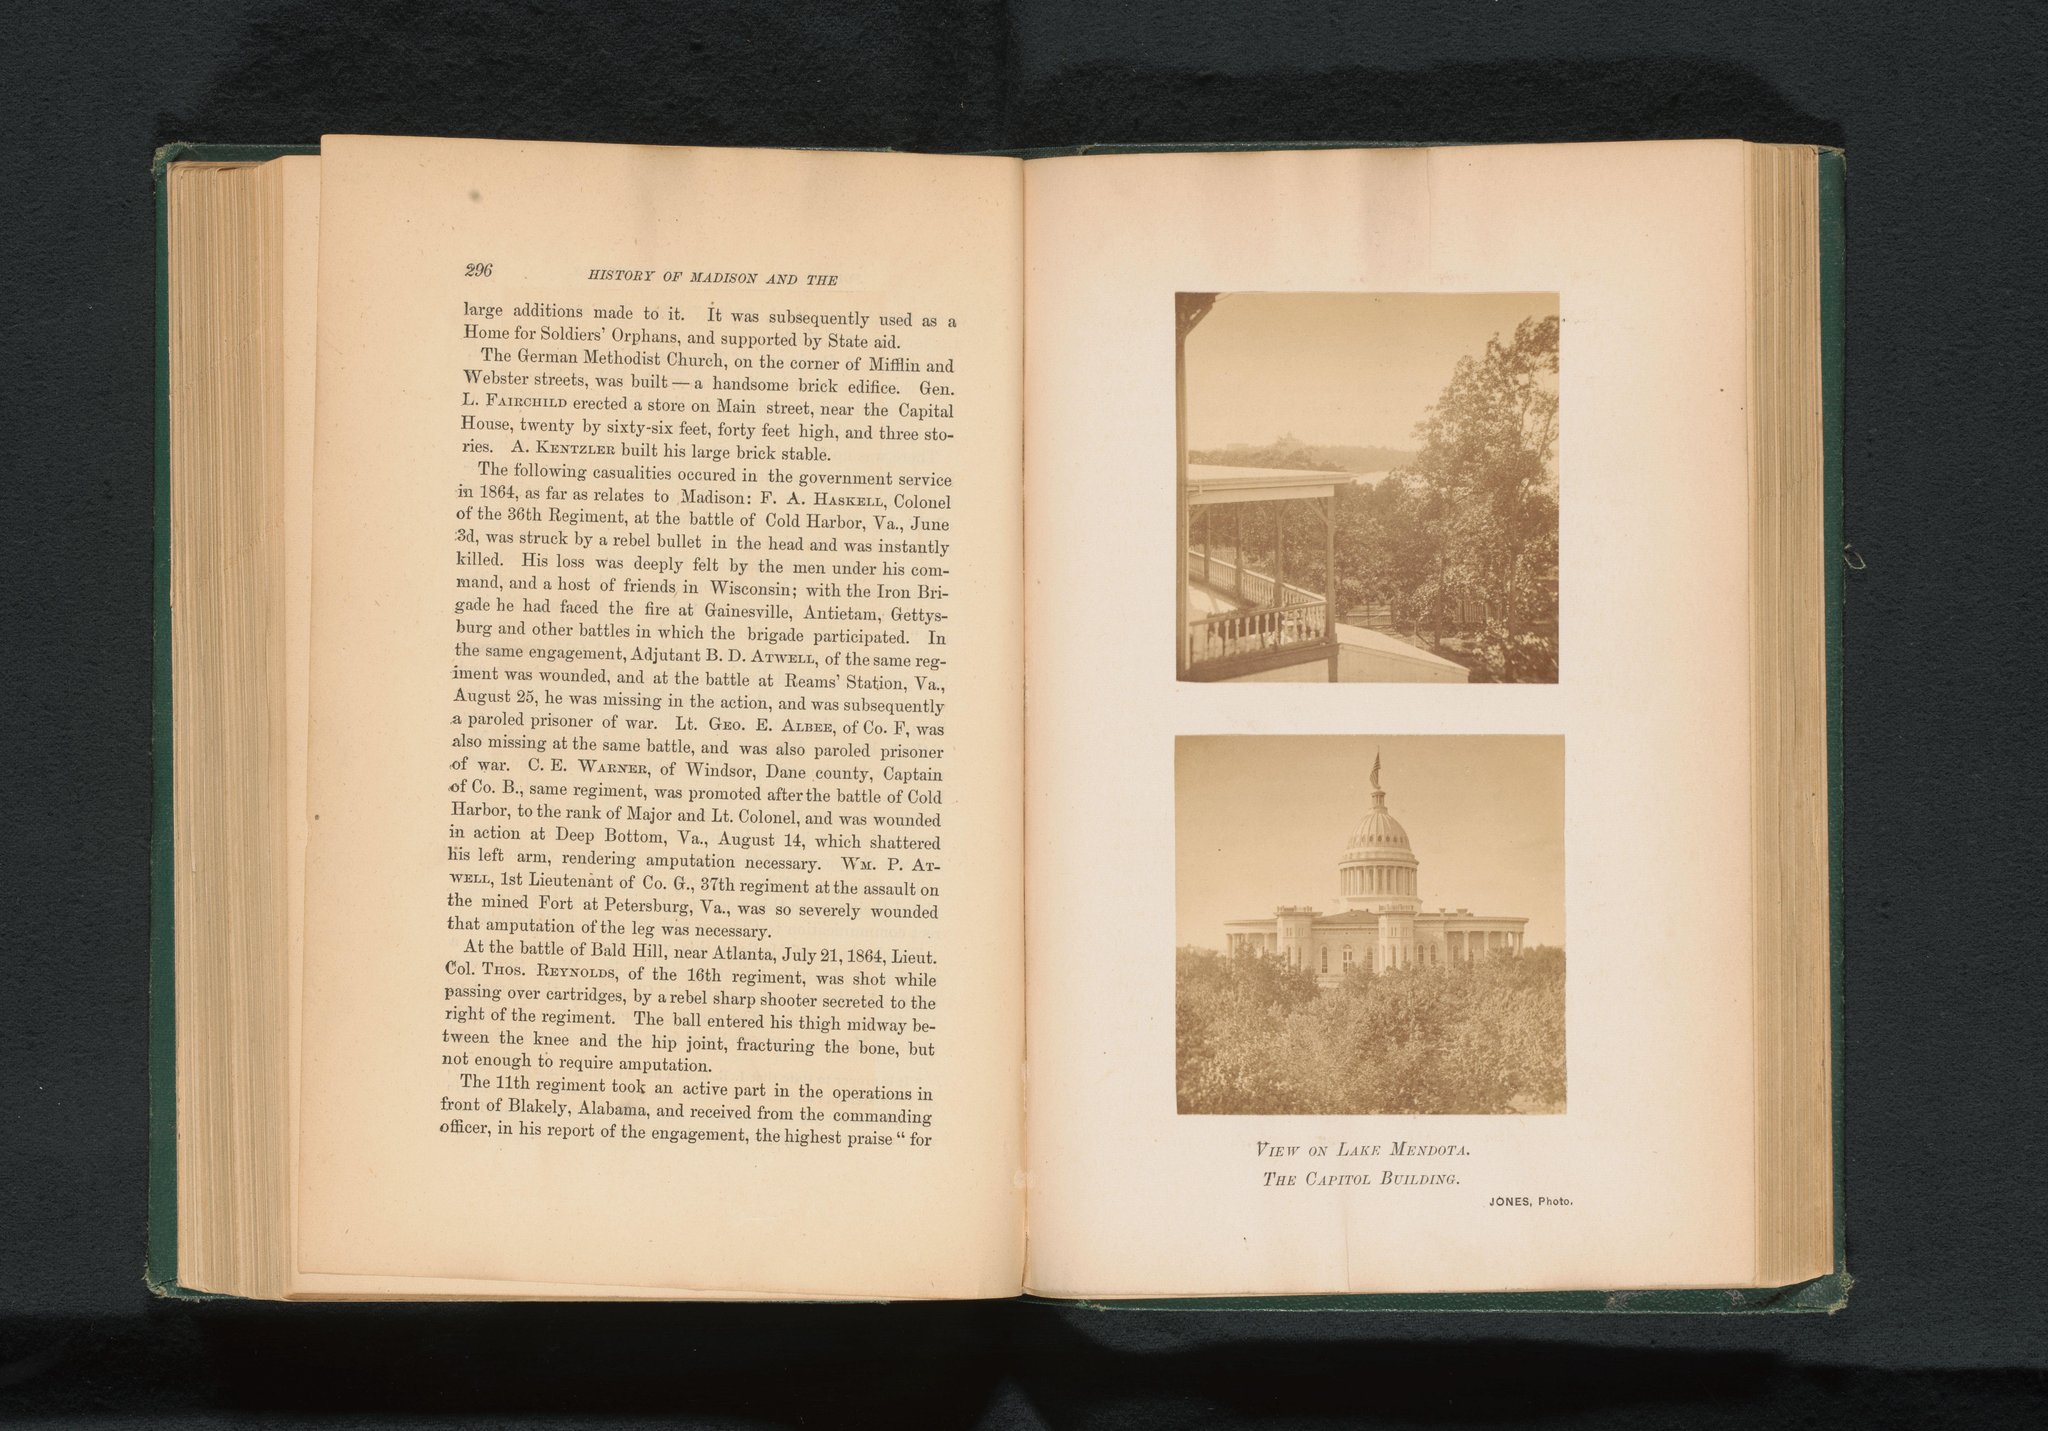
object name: page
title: Gezicht op Lake Mendota en het Wisconsin State Capitol in Madison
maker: jones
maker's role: fotograaf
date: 1864-1874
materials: photographic support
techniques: albumen print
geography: madison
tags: lake, state; law; political life